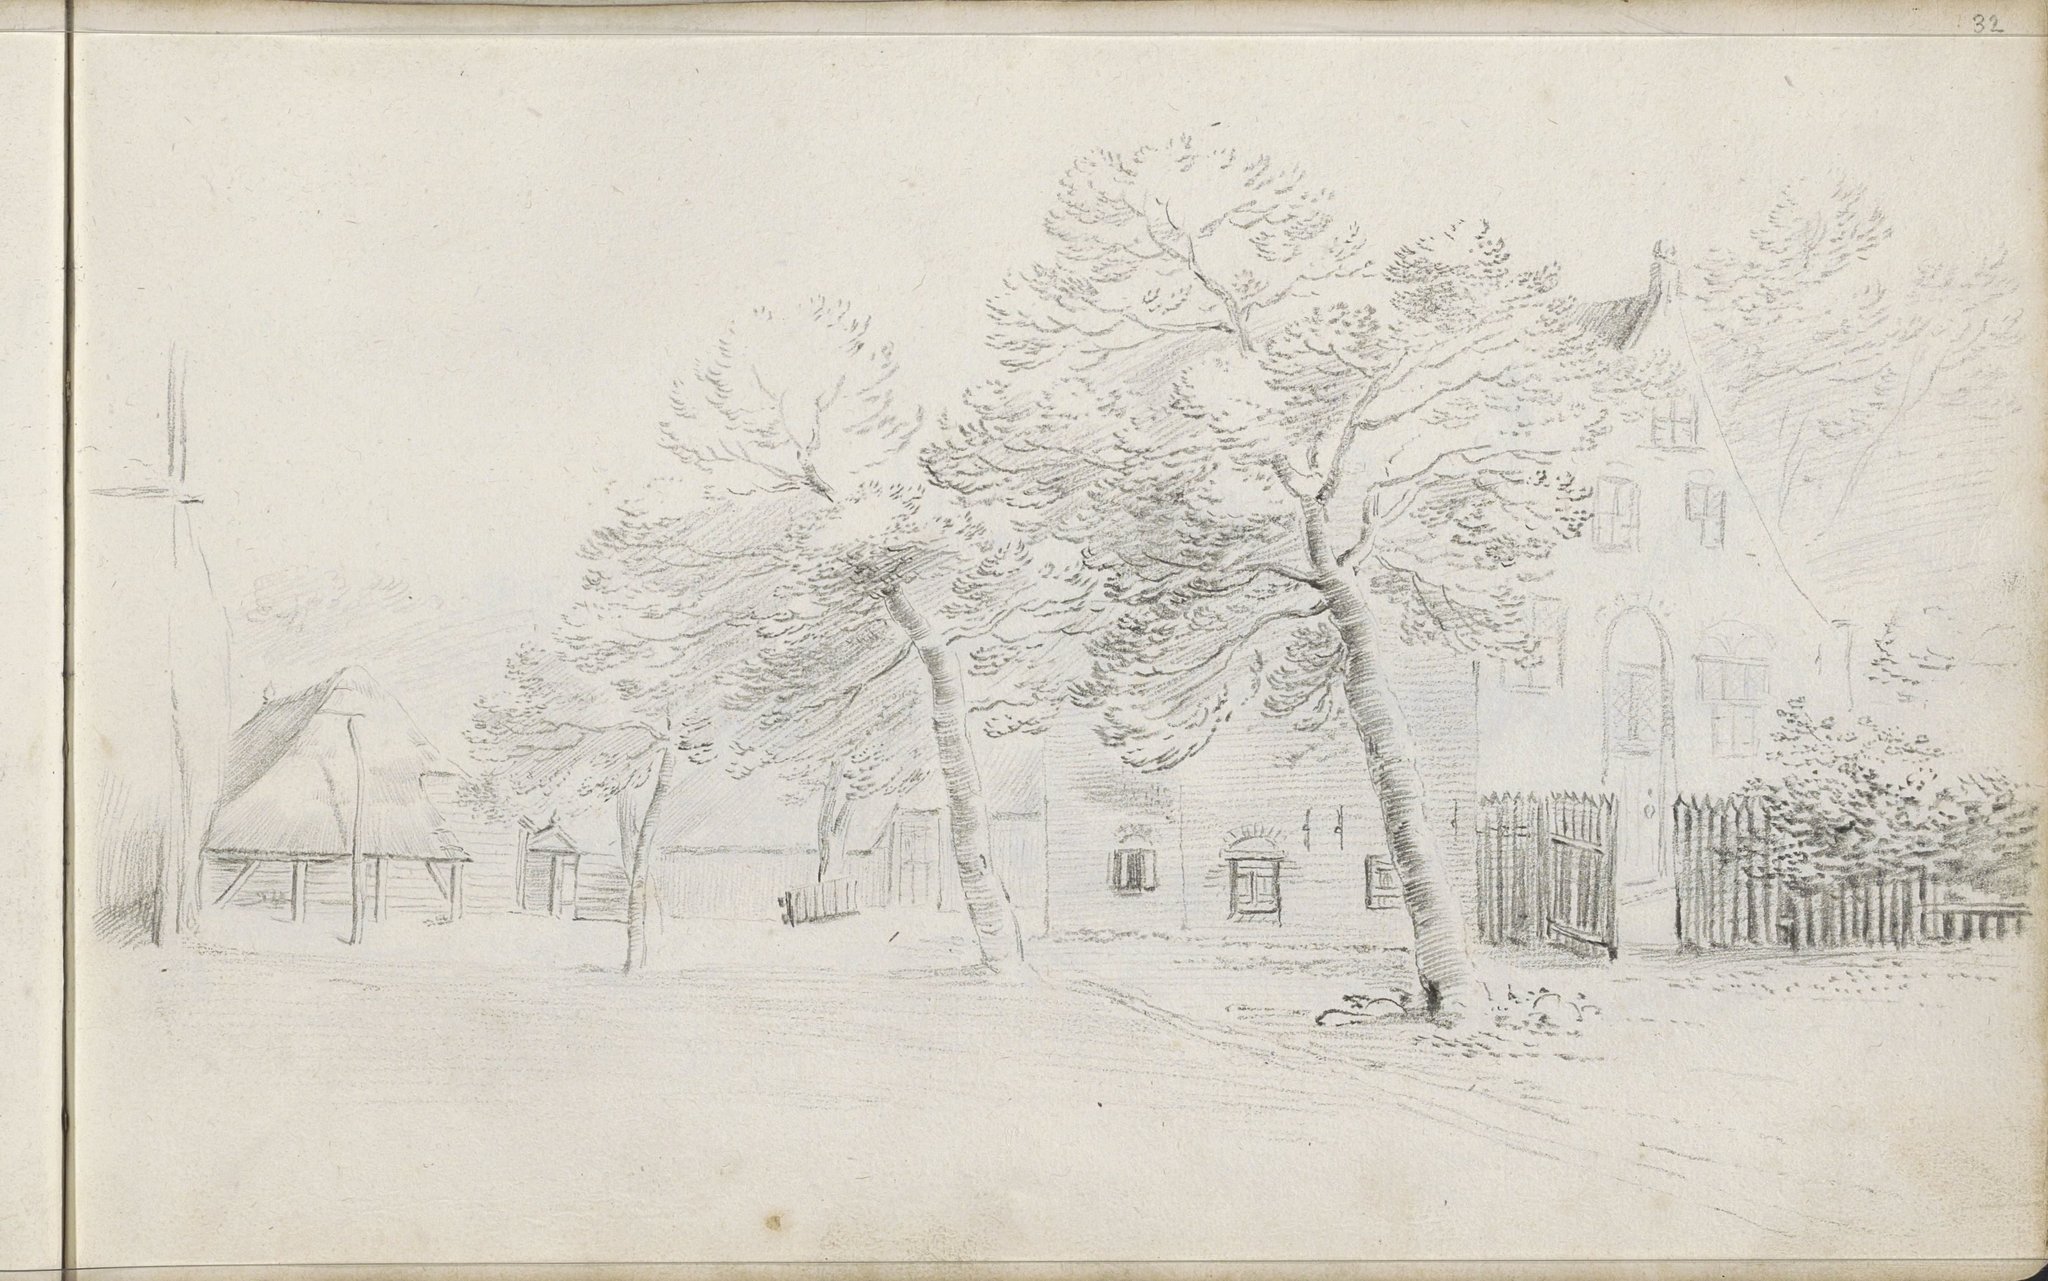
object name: sketchbook leaf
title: Boerenerf met een hooimijt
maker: pieter moninckx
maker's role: draughtsman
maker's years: 1606-1686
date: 1645-1646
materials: chalk, paper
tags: farm or solitary house in landscape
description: Blad 32 recto uit een schetsboek met 39 bladen.